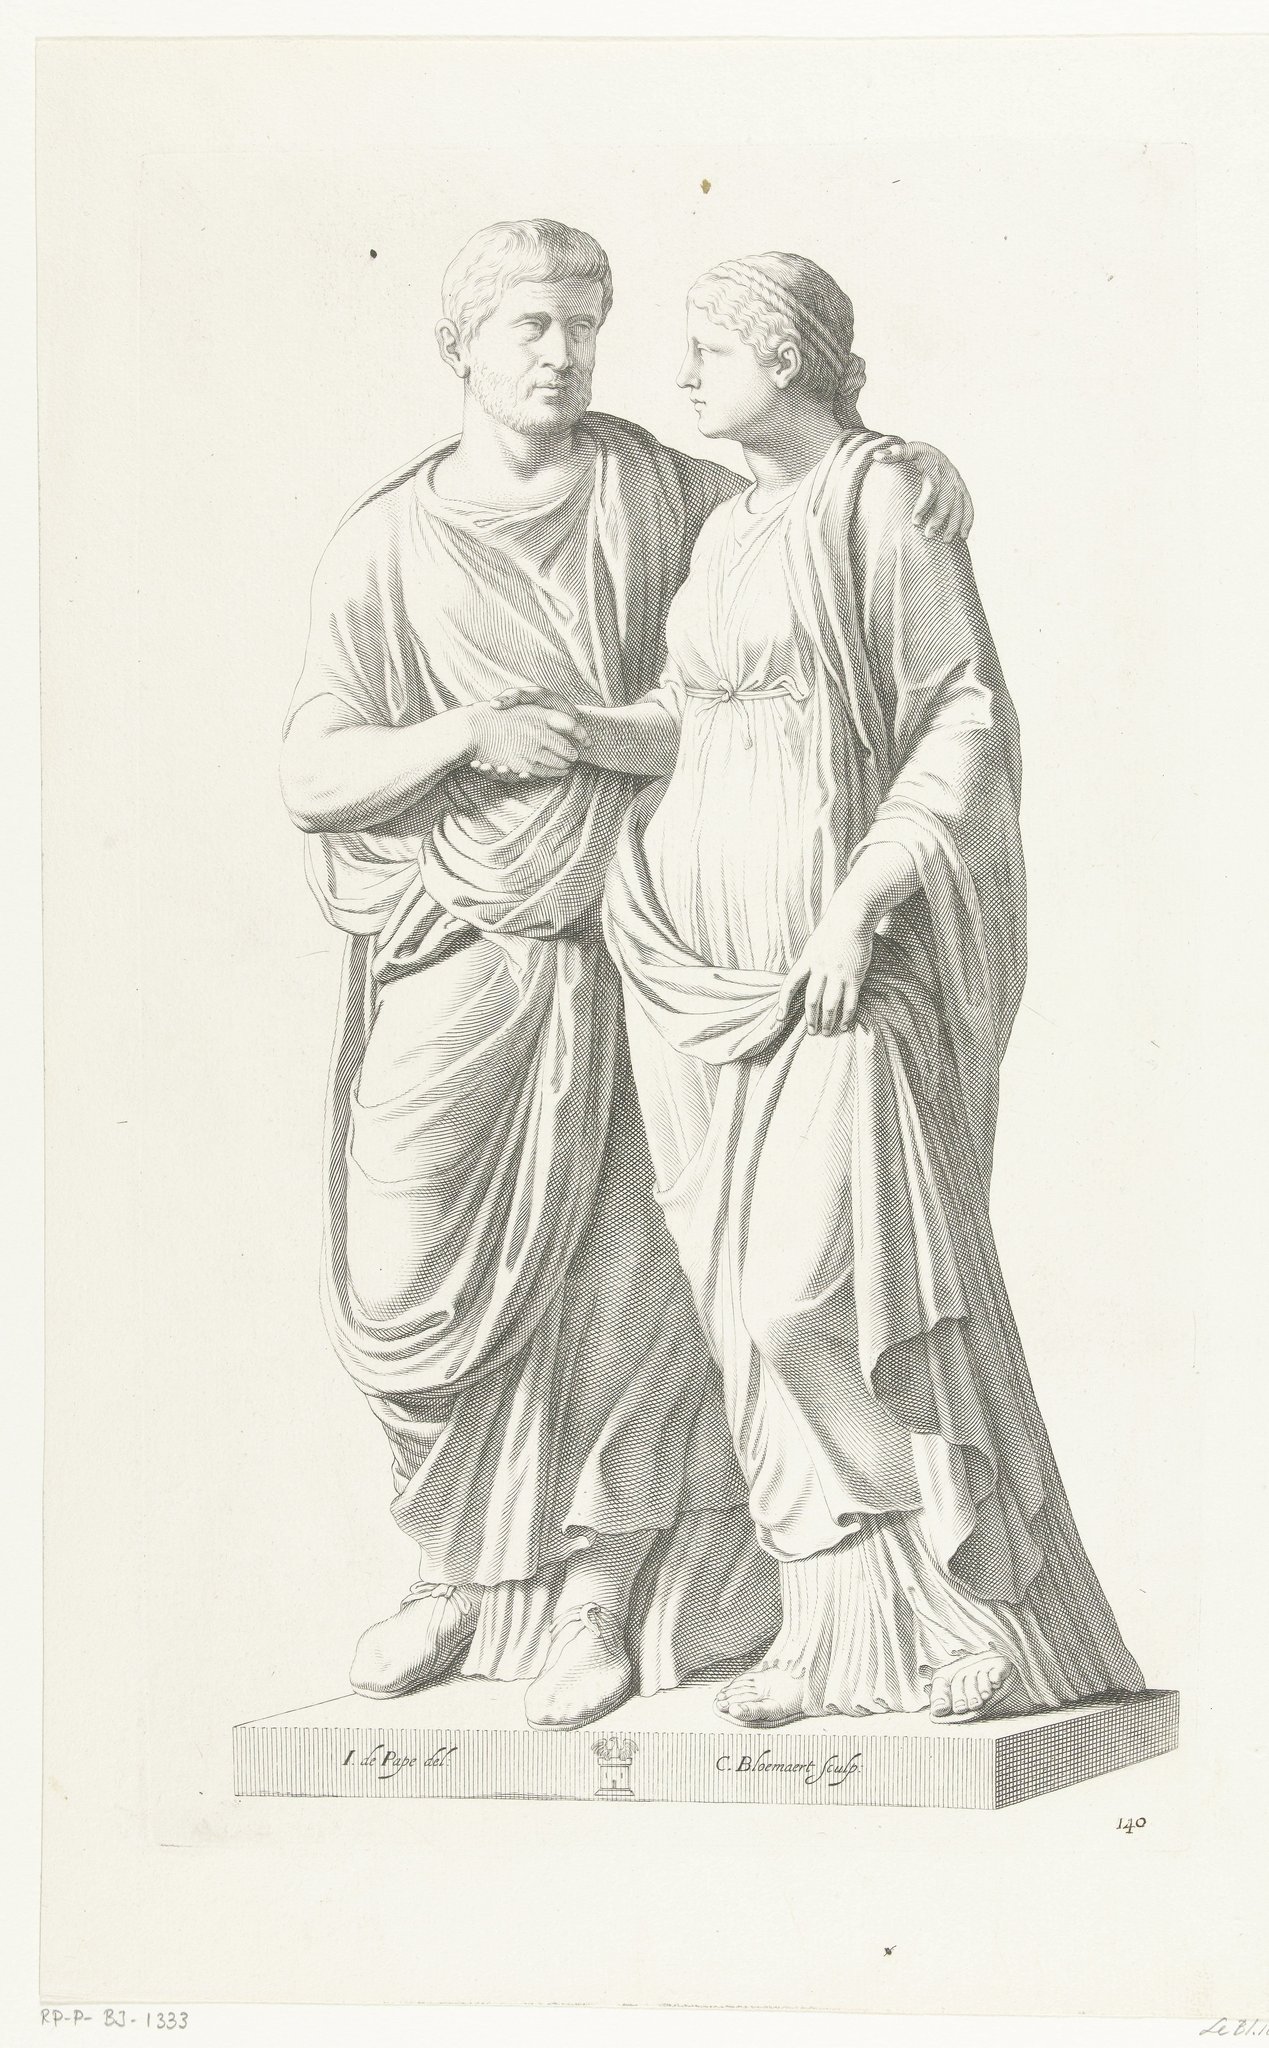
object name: print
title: Man en een vrouw reiken elkaar de hand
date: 1636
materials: paper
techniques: engraving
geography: rome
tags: piece of sculpture, reproduction of a piece of sculpture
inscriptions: number: ‘140’, collector's mark: Lugt 2228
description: Beeld van een man en een vrouw in Romeinse kleding die elkaar de hand reiken. Het beeld is afkomstig uit de collectie van Vincenzo Giustiniani, wiens wapen op de sokkel te zien is.